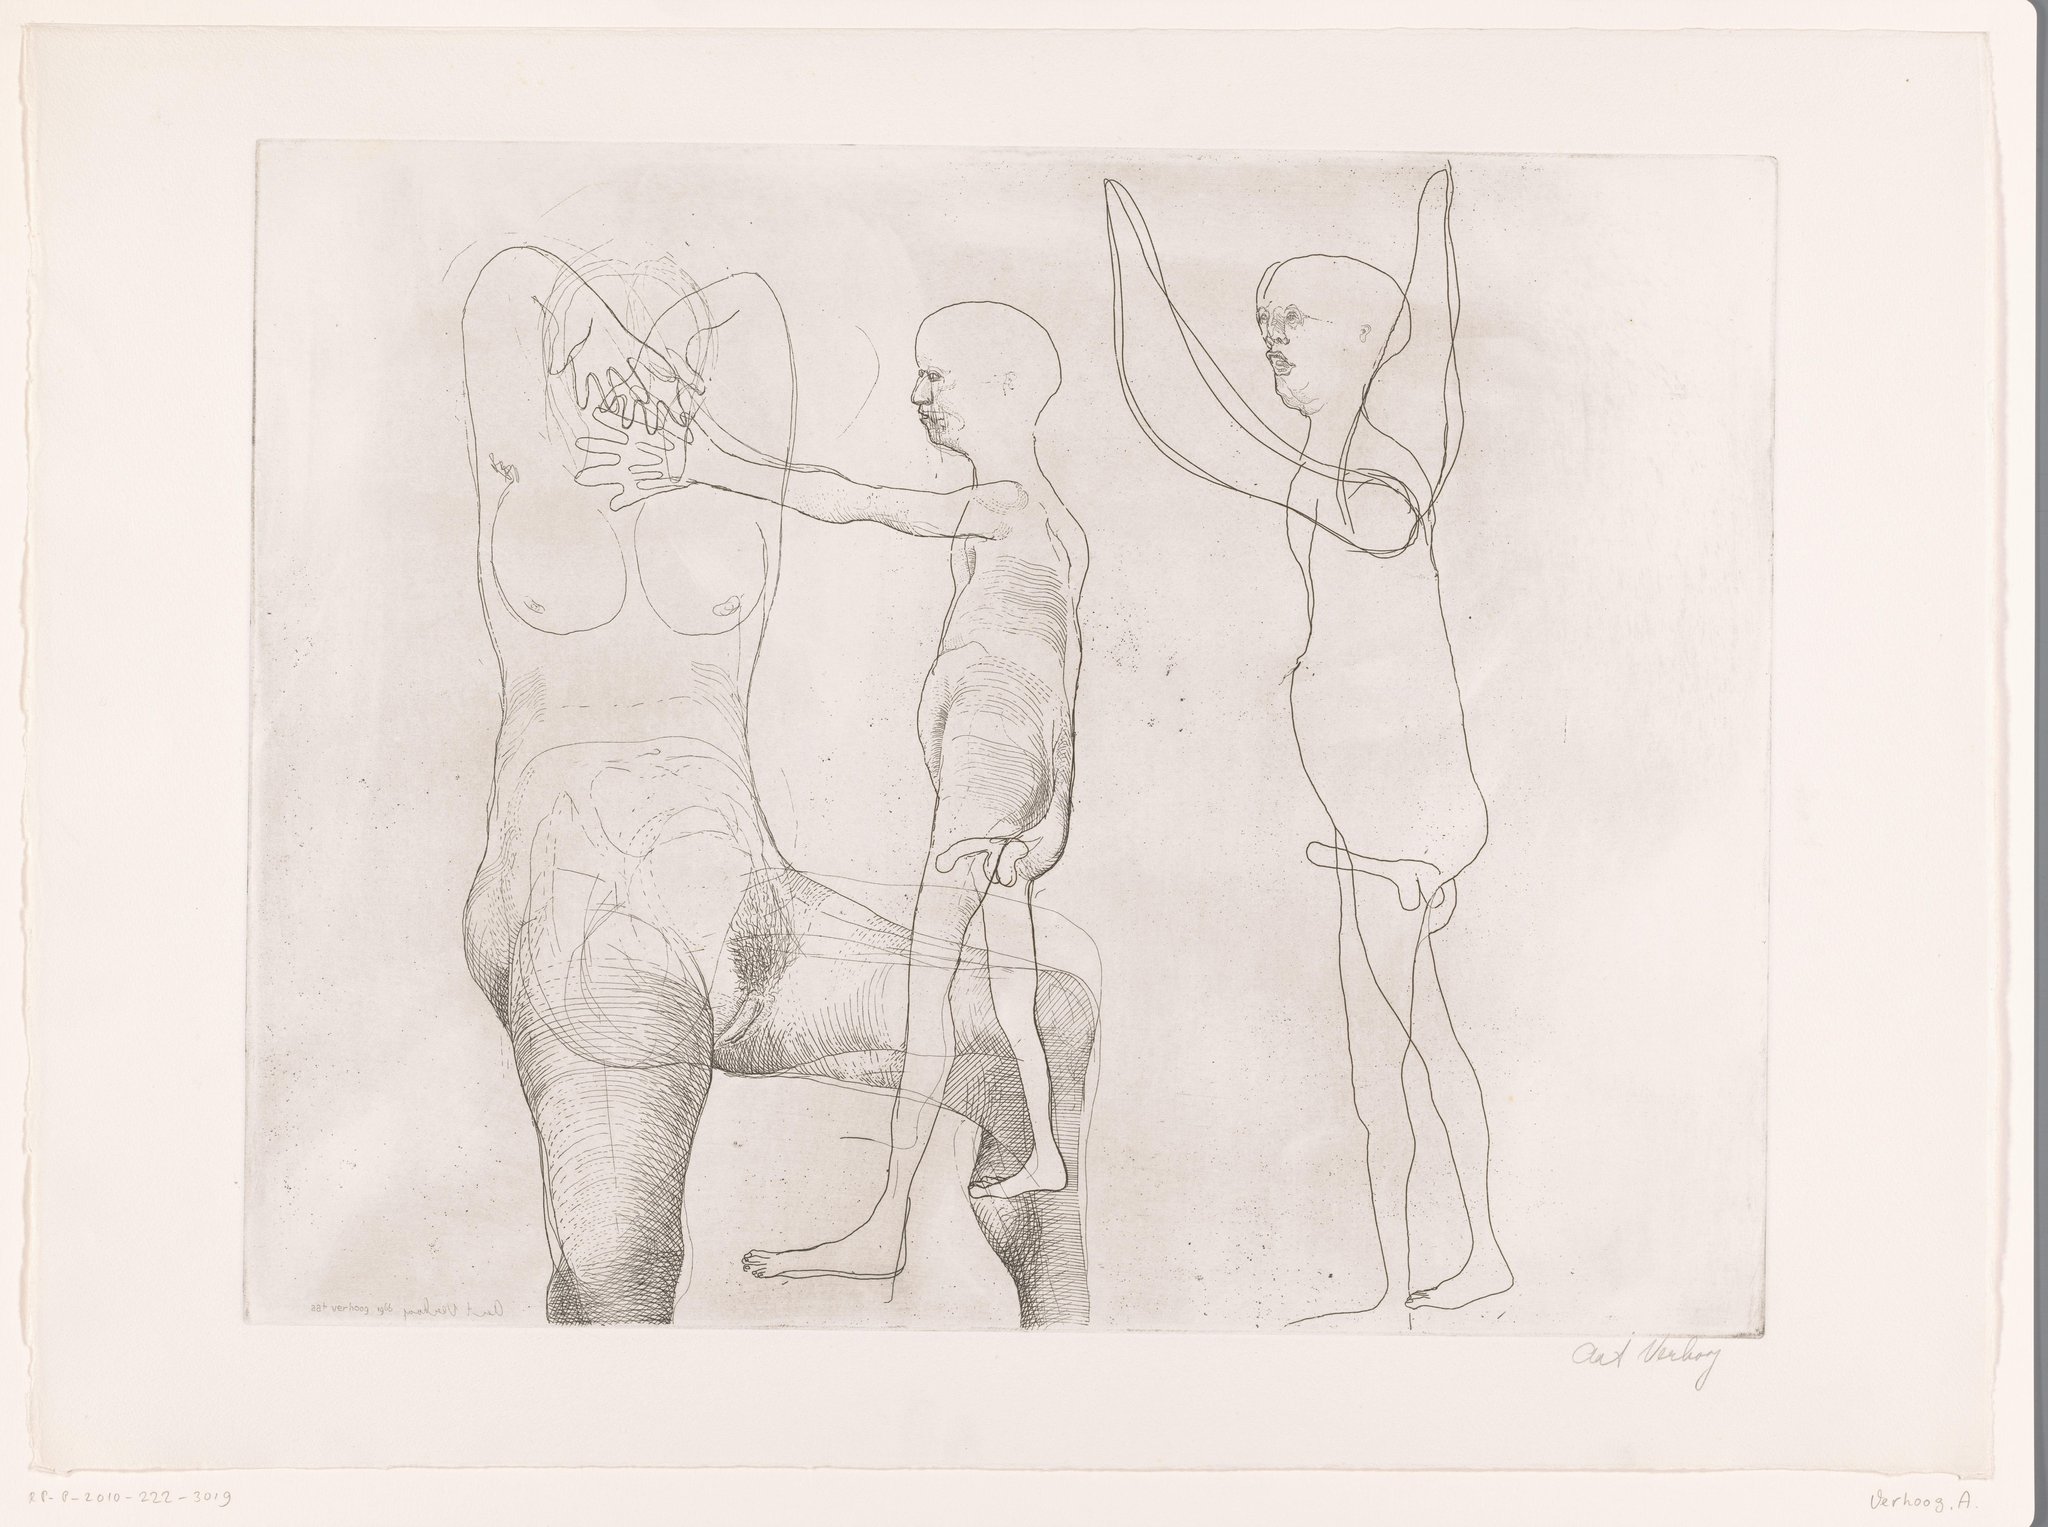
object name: print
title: Drie naakten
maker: aat verhoog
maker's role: print maker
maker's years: 1933-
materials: paper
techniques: etching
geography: amsterdam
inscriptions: signature: ‘Aat Verhoog’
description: Rechts twee naakte mannen met uitgestrekte armen lopend naar links waar zich een buitenproportioneel groot naakt lichaam van een vrouw bevindt.